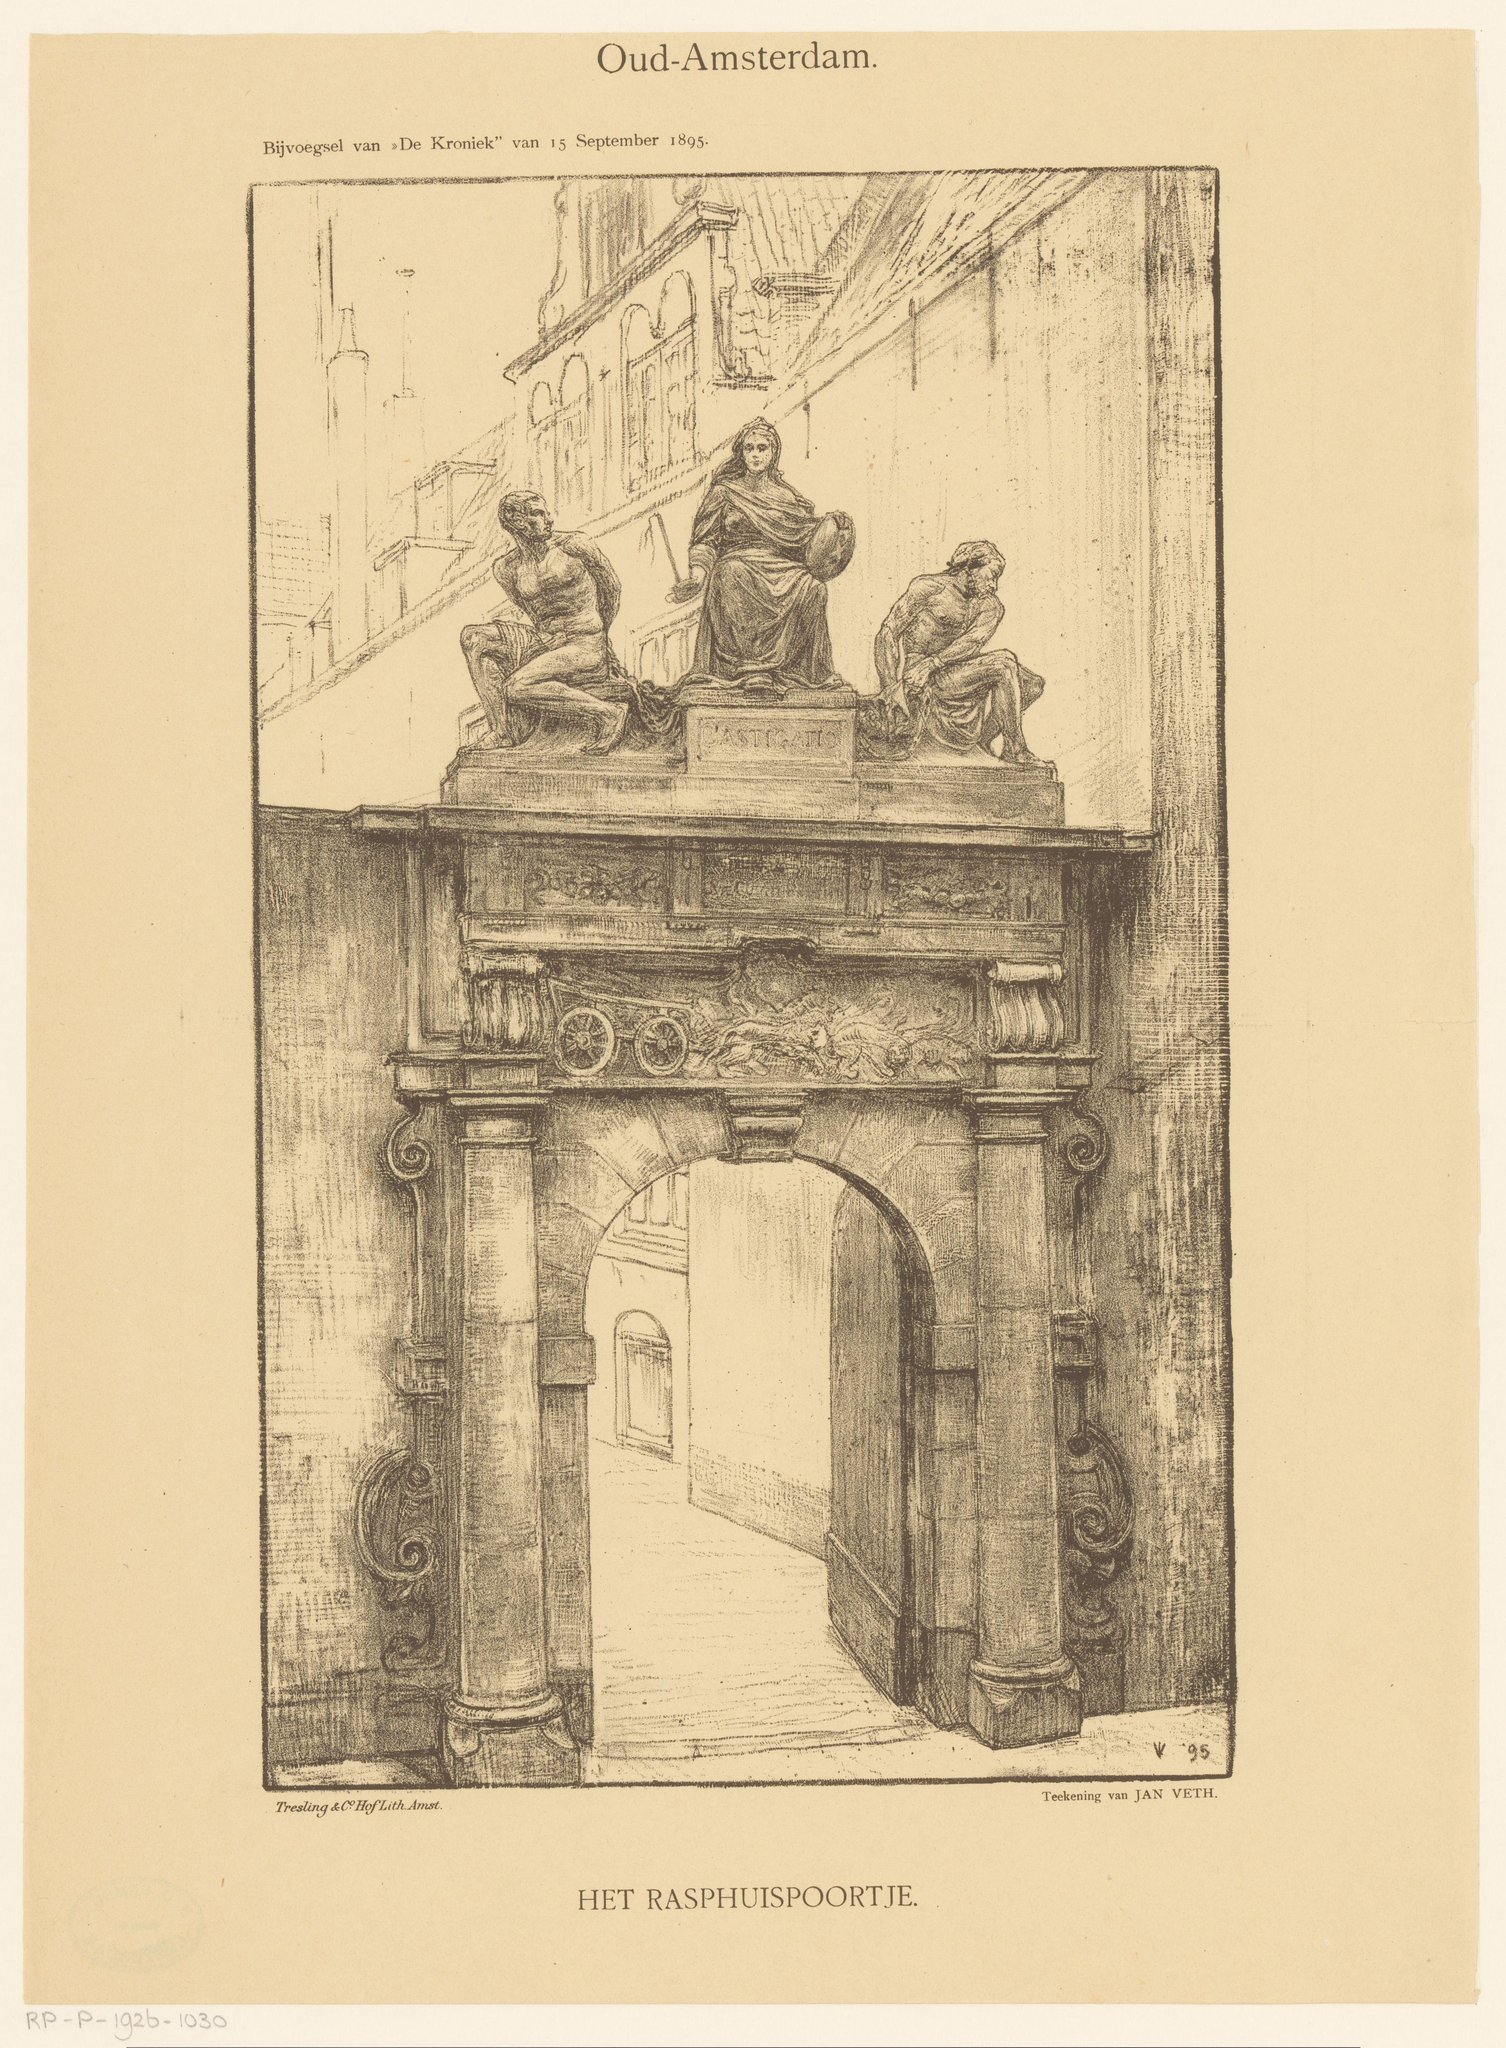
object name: print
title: Oud-Amsterdam / Het Rasphuispoortje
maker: jan veth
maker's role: designer, draughtsman, painter, print maker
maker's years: 1864-1925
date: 1895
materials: paper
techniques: lithograph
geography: netherlands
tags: gate, entrance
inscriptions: collector's mark: ‘H.G. Samson Amsterdam’, collector's mark: Lugt 2228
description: De Rasphuispoort gaf toegang tot een tuchthuis voor zwervers en bedelaars en later een verbeterhuis voor jongeren: het Rasphuis.